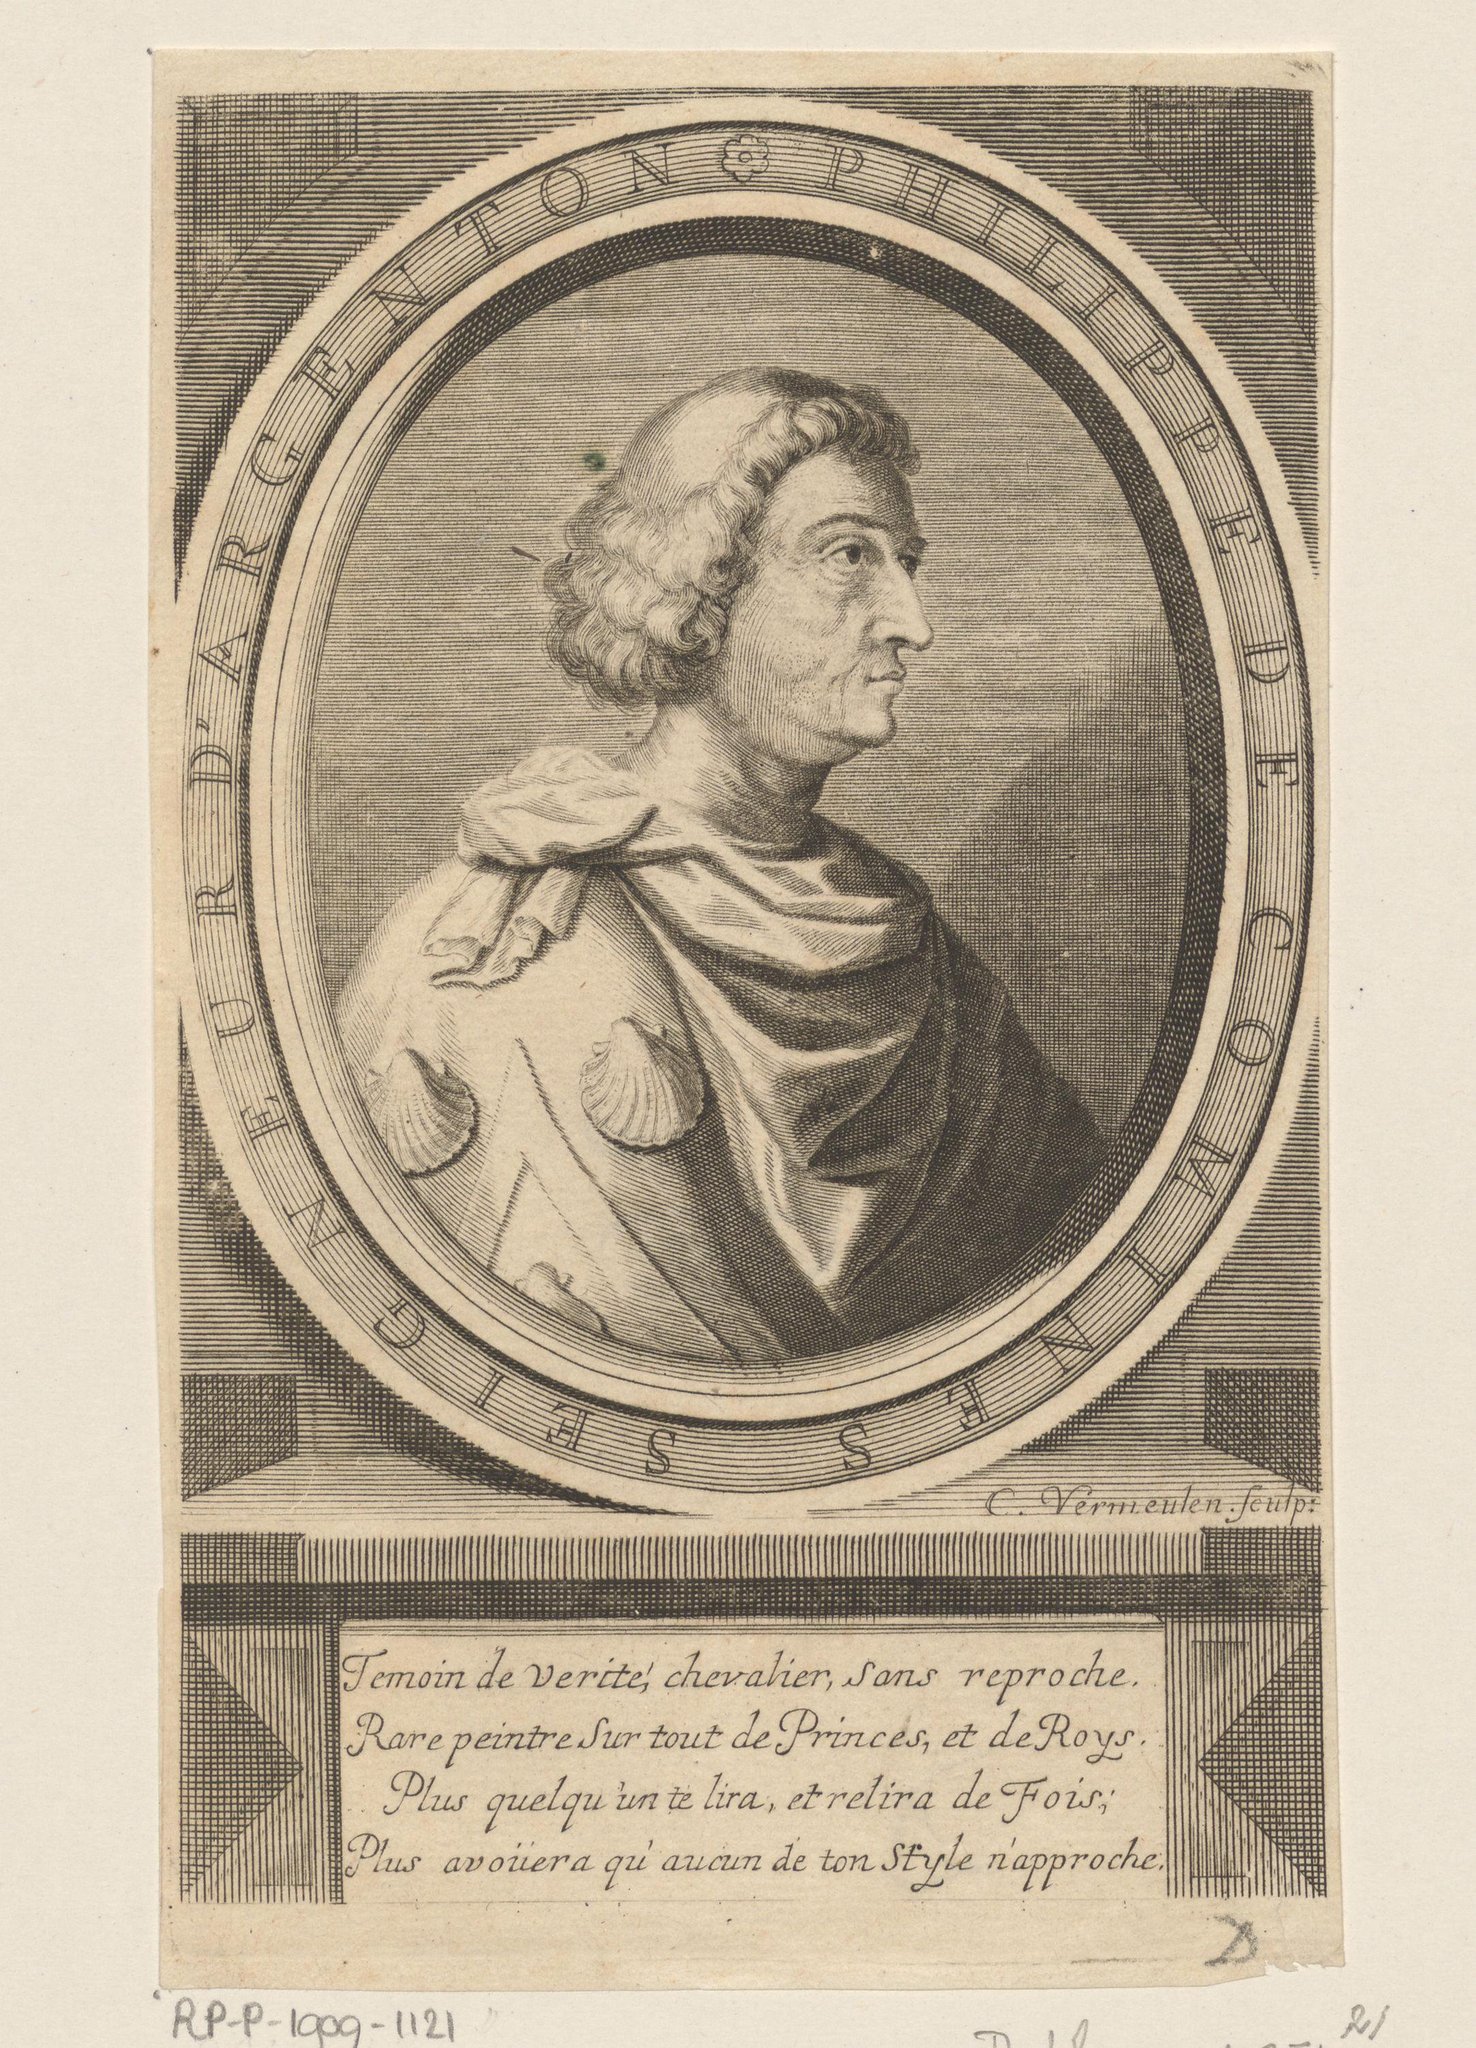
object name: print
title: Portret van Philippe de Comines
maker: cornelis martinus vermeulen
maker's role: print maker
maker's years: 1644-1709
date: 1823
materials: paper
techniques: engraving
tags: historical persons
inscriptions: collector's mark: Lugt 2228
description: Prent mogelijk uit: Godefroy, Denis. Memoires de messire Philippe (...). Brussel: Francois Foppens, 1723.